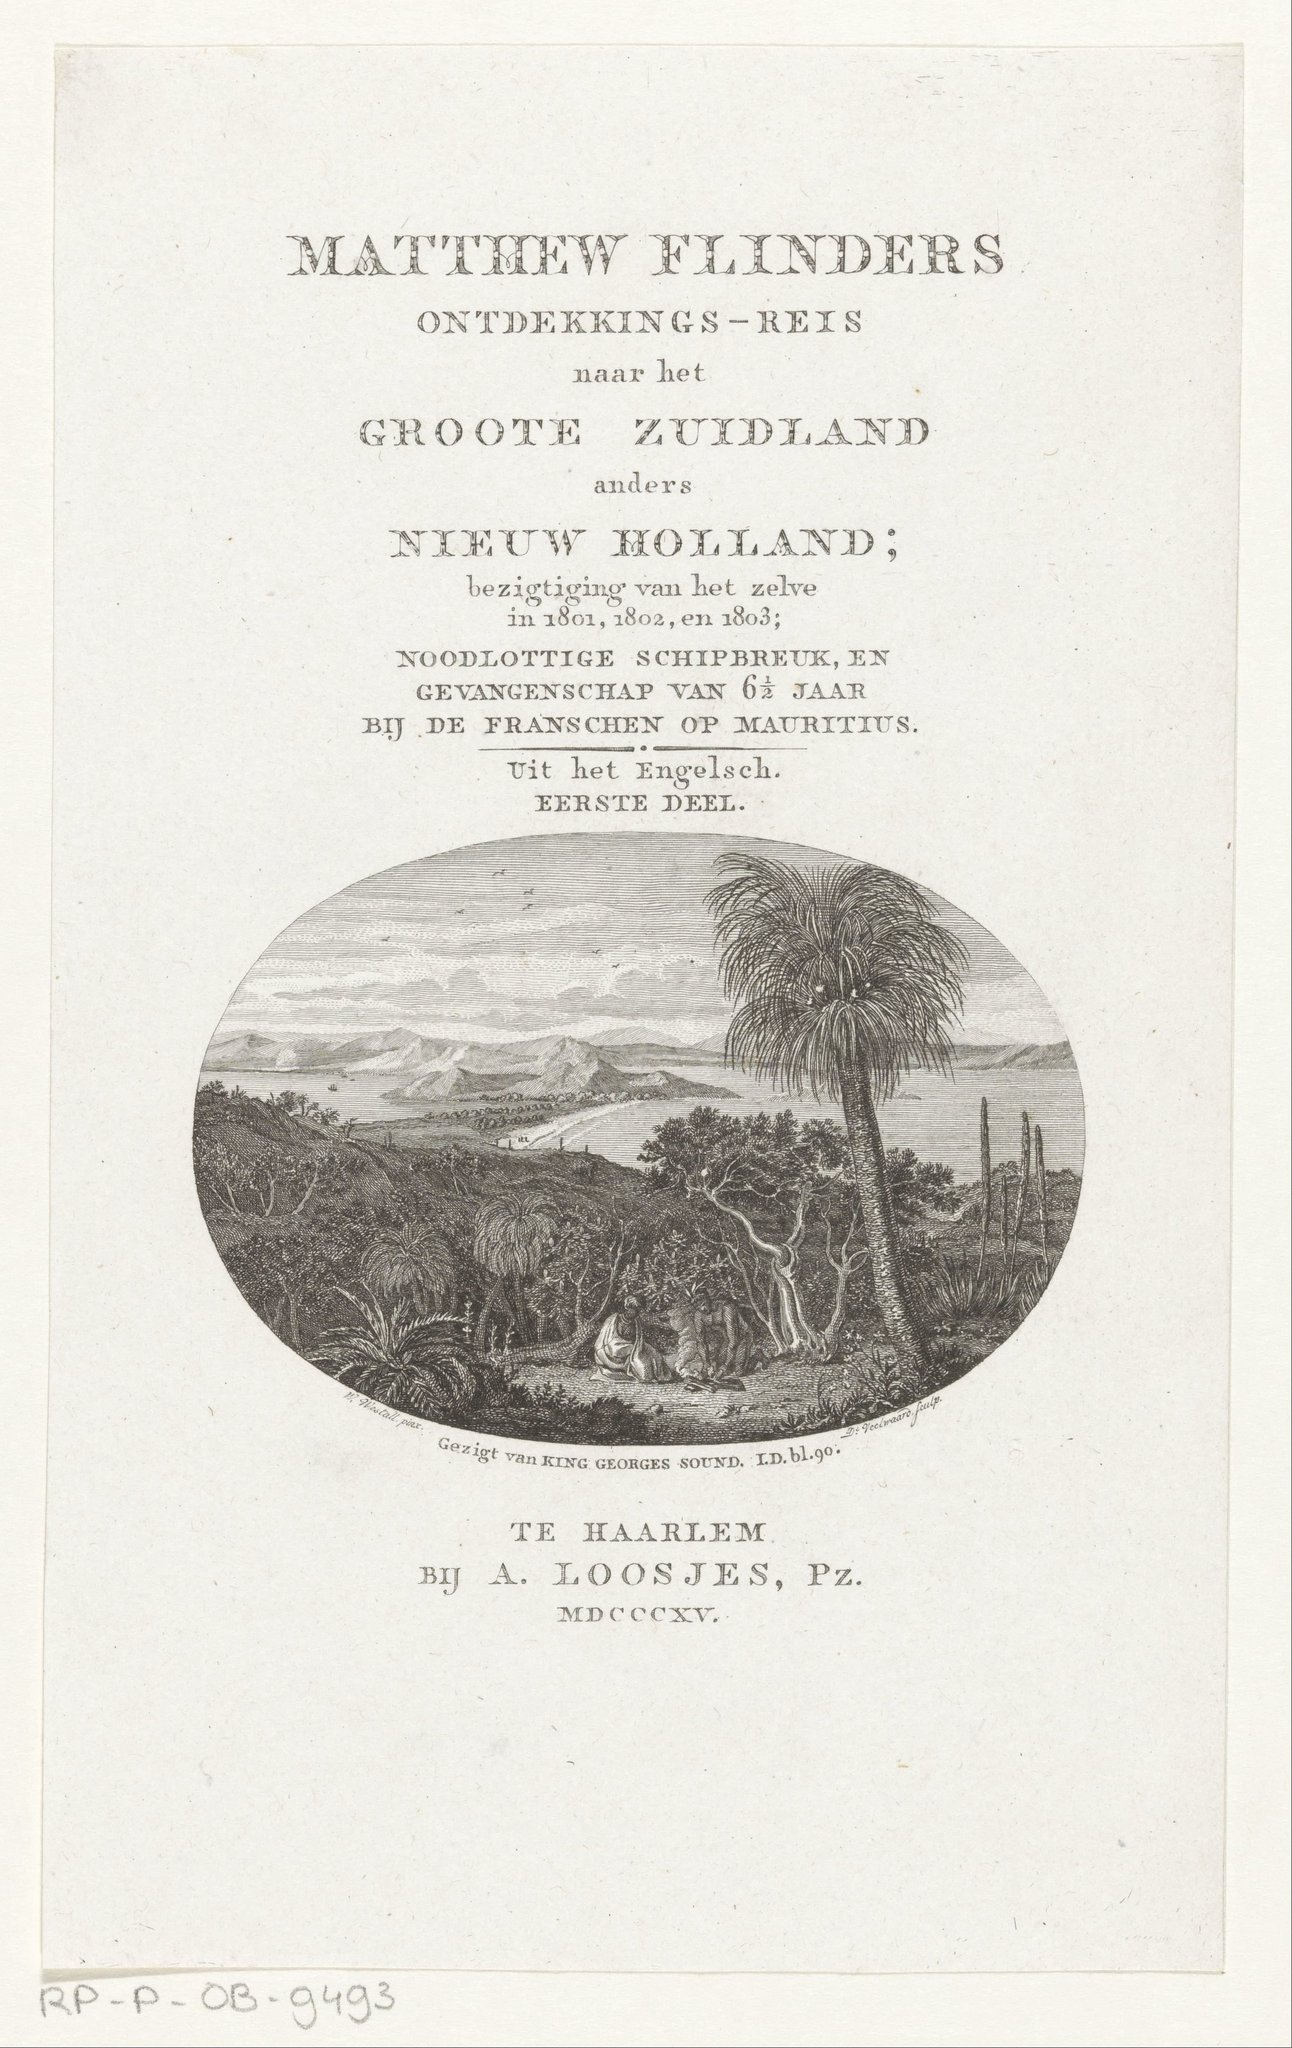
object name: titelblad, titelpagina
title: Titelpagina voor: Matthew Flinders, Ontdekkings-reis naar het Groote Zuidland anders Nieuw Holland, 1815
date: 1815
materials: paper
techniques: engraving, etching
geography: haarlem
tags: island, sea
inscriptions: collector's mark: Lugt 2228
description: Titelpagina voor: Flinders, Matthew. Ontdekkings-reis naar het Groote Zuidland ander Nieuw Holland, eerste deel. Haarlem: Loosjes, Adriaan Pietersz., 1815.